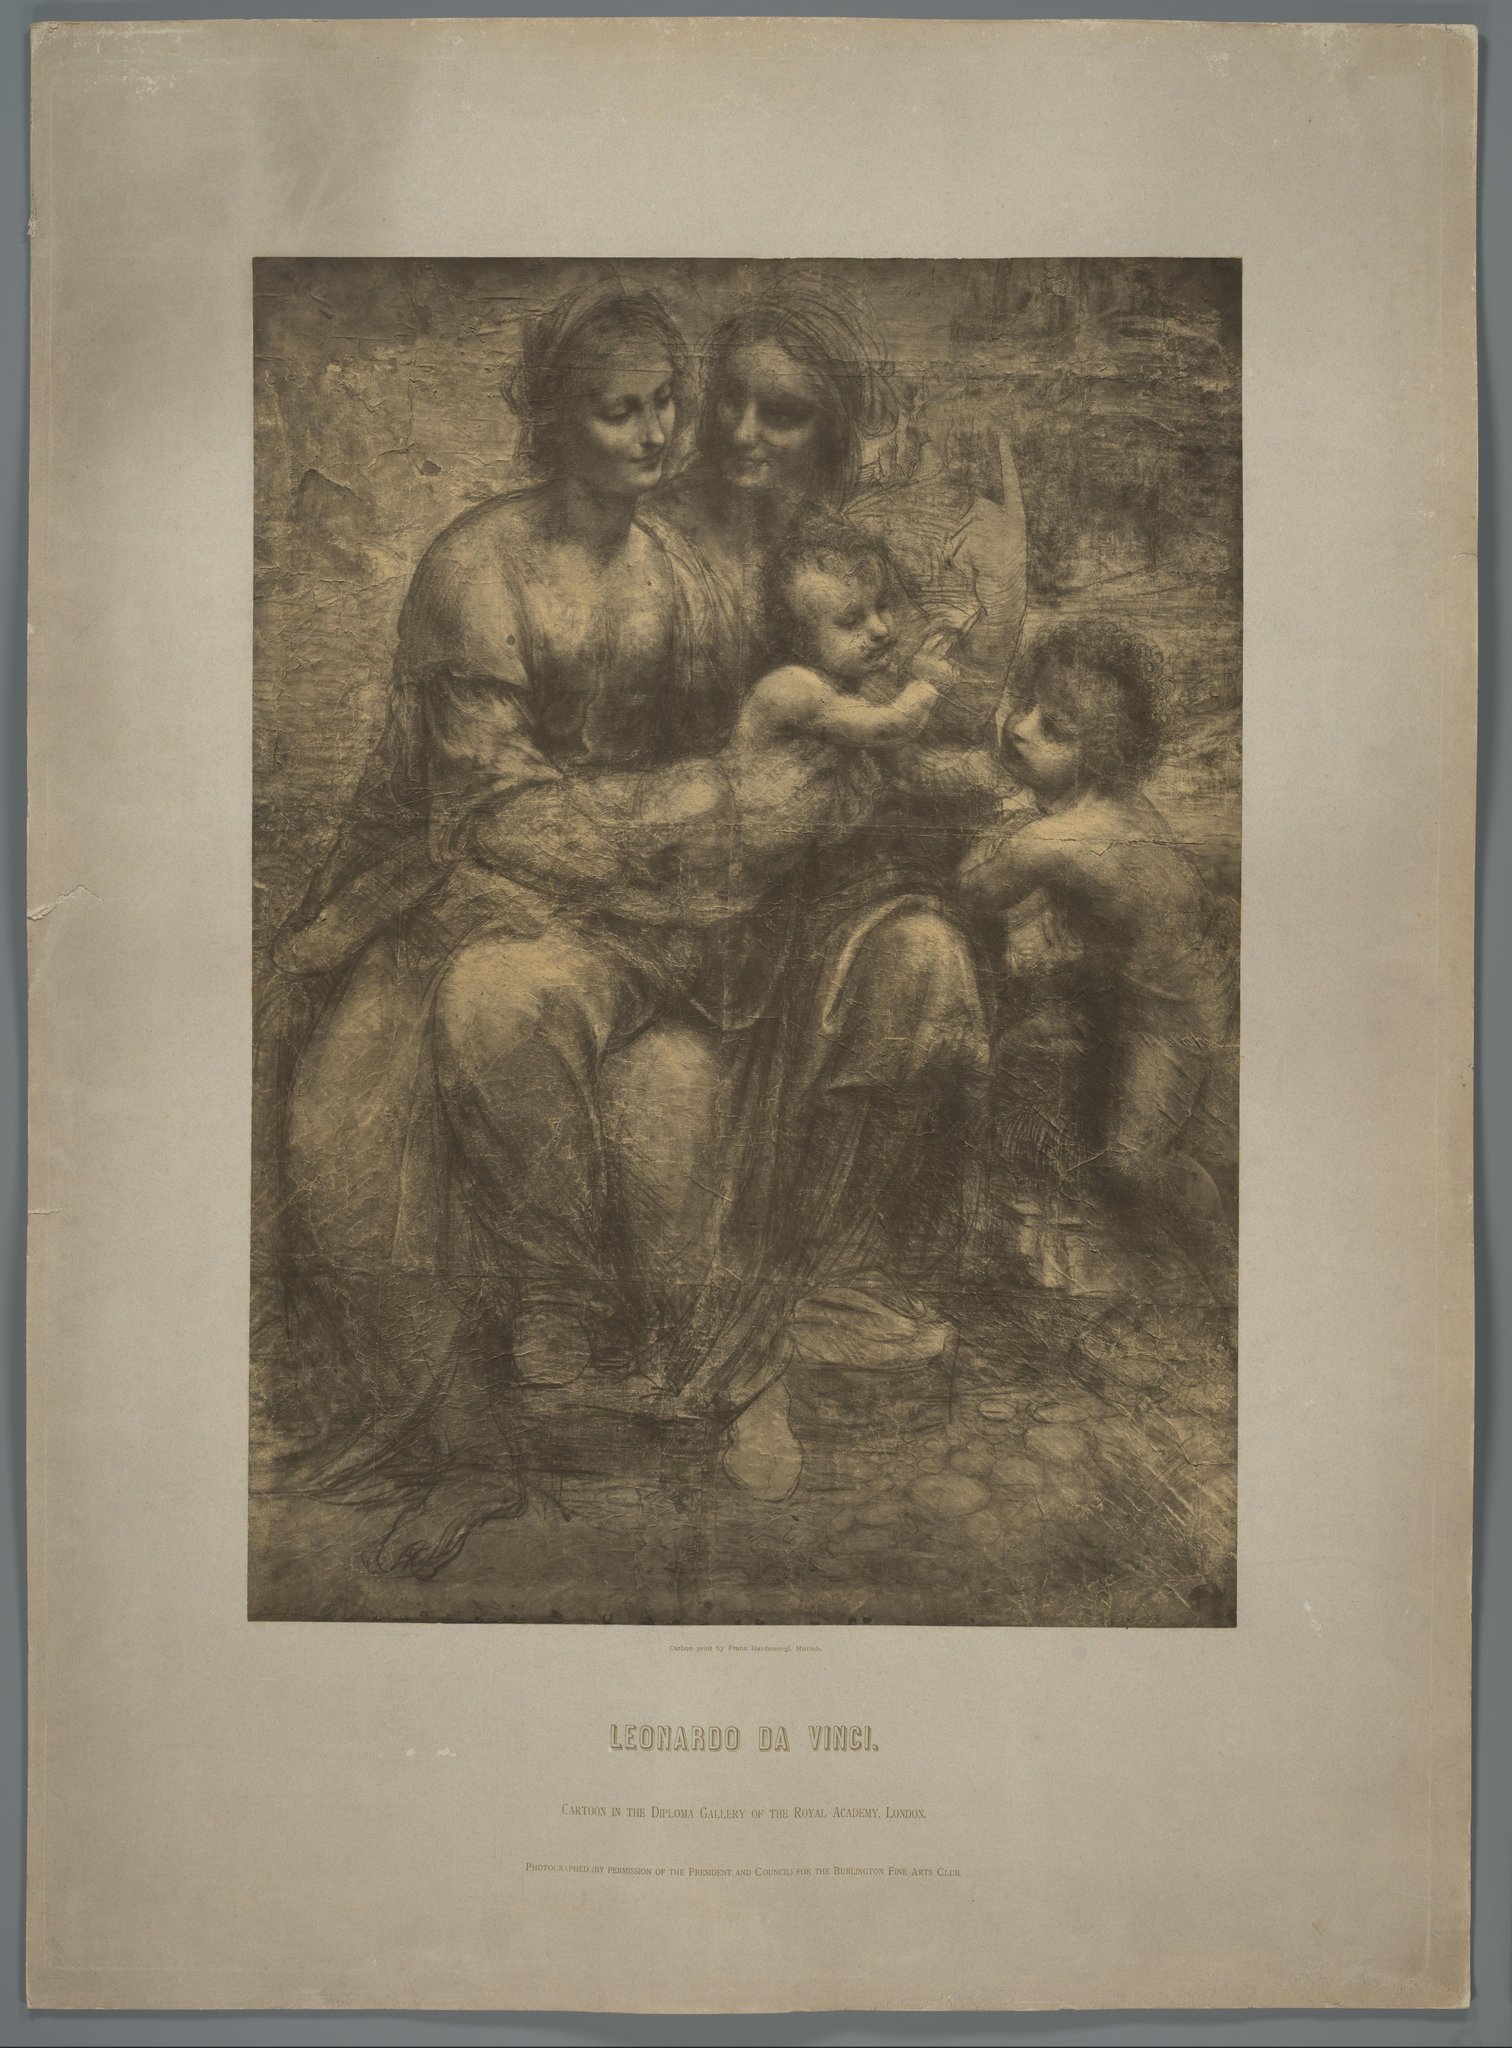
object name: reproduction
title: Fotoreproductie van de tekening van Maria, Christus, Sint-Anna en Johannes de Doper door Leonardo da Vinci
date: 1870-1890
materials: cardboard, paper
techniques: carbon print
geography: london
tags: john the baptist; possible attributes: book, reed cross, baptismal cup, honeycomb, lamb, staff, anna, mother of mary; possible attributes: book, christ-child, lily, virgin mary, madonna (i.e. mary with the christ-child) accompanied or surrounded by others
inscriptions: inscription: ‘Photographed (by Permission of the President and Council) for the Burlington Fine Arts Club.’